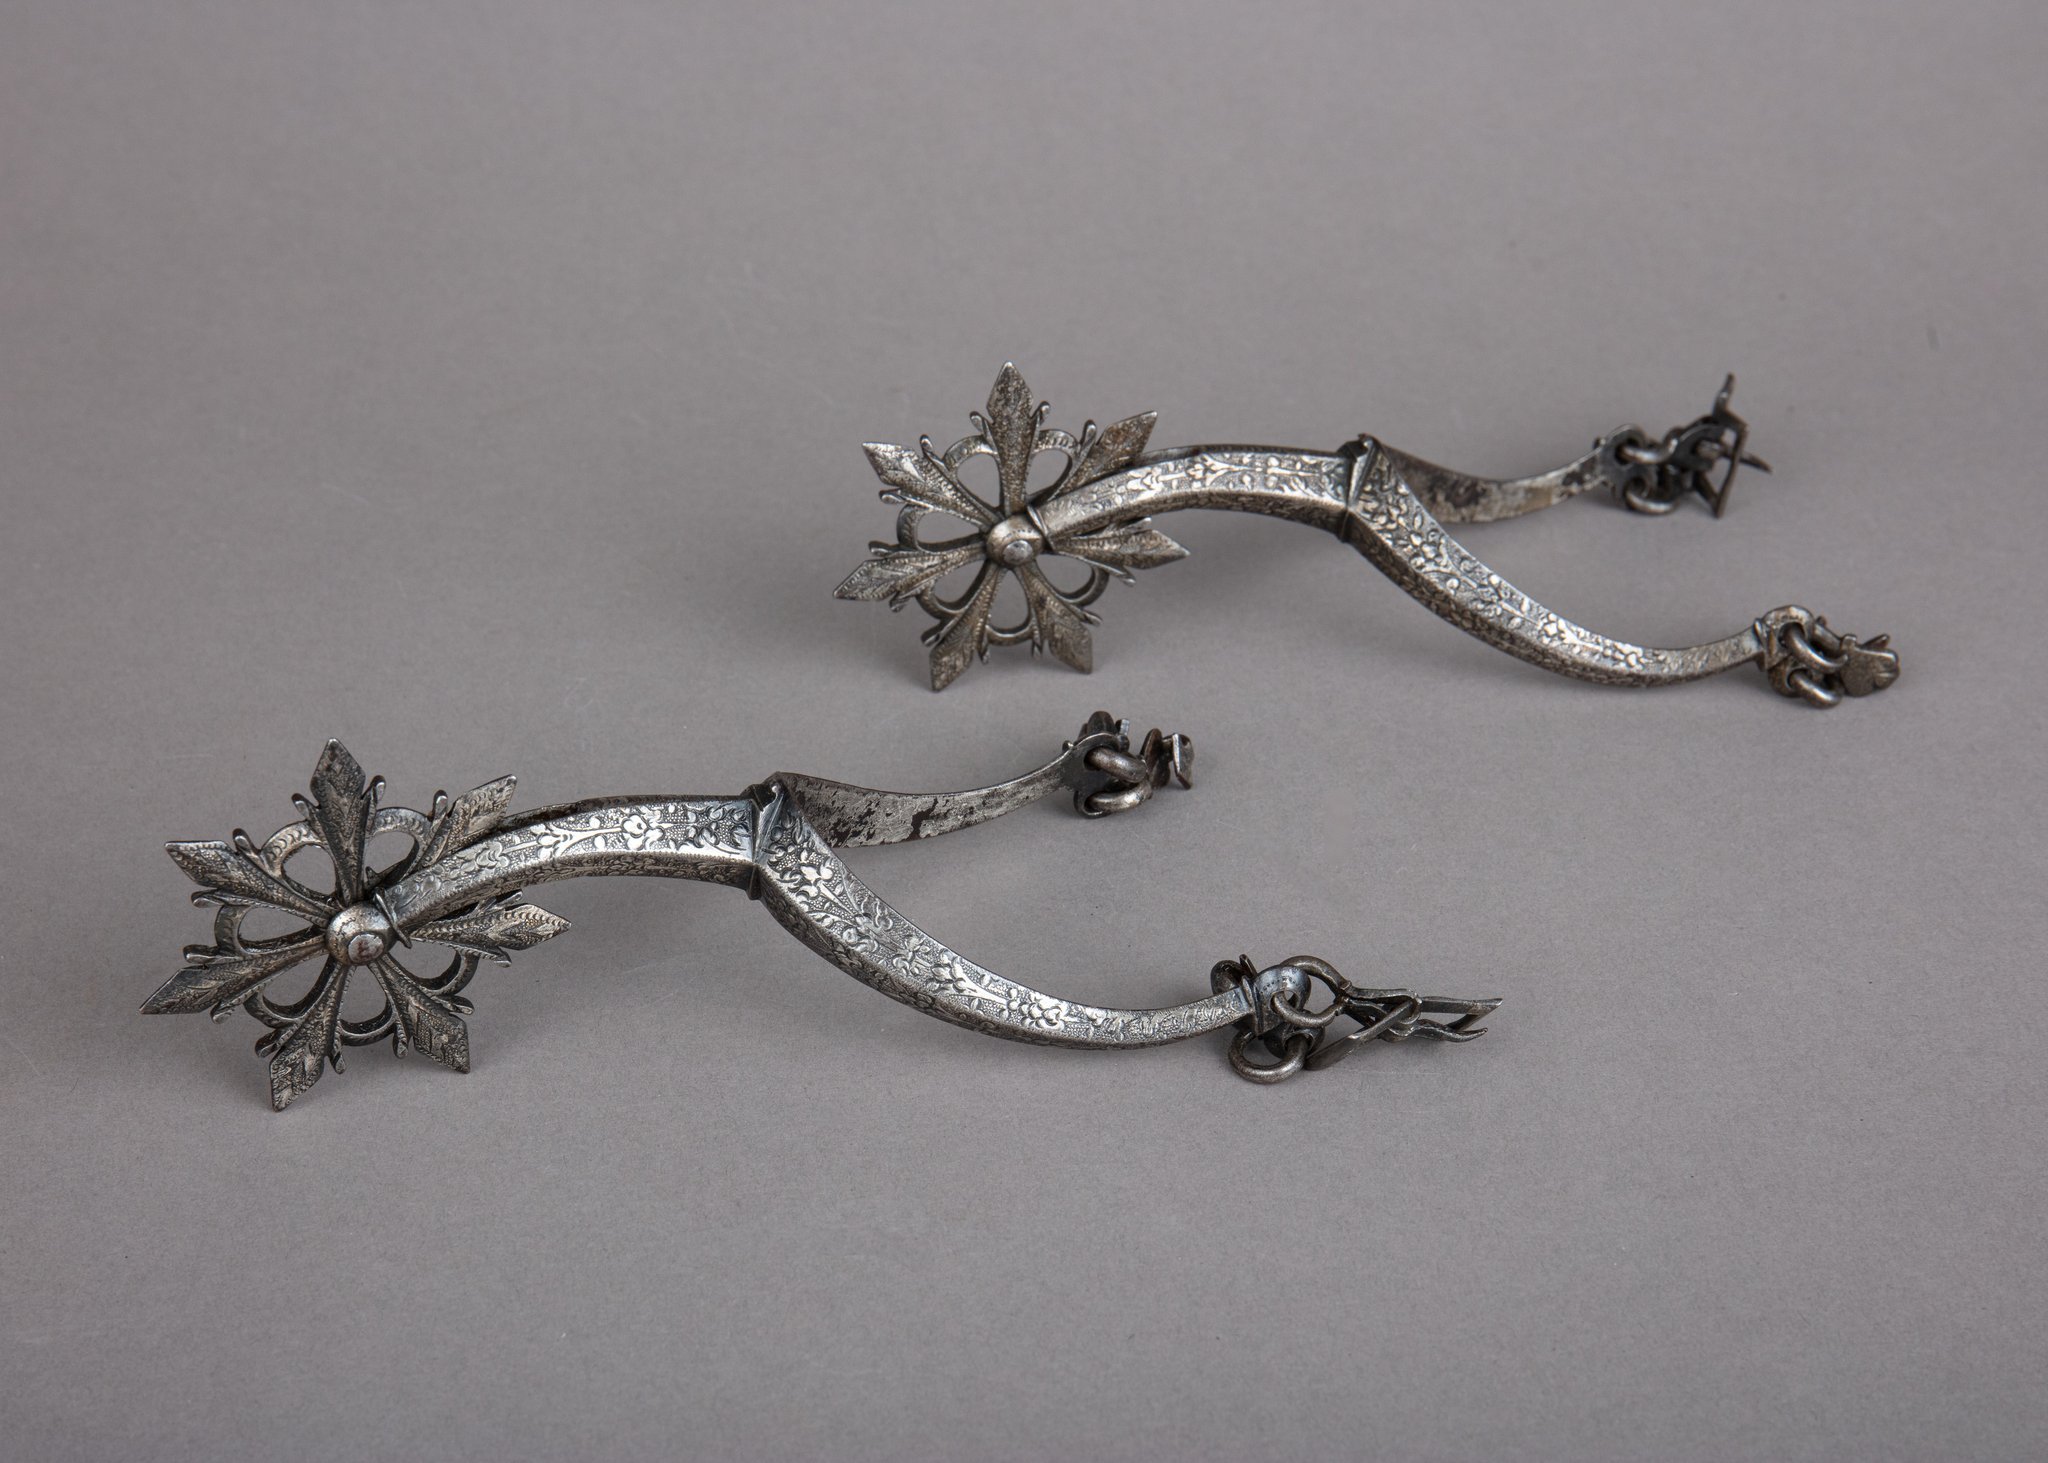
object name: spur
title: Pair of Rowel Spurs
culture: german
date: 1601-1633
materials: metal alloy, silver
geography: germany